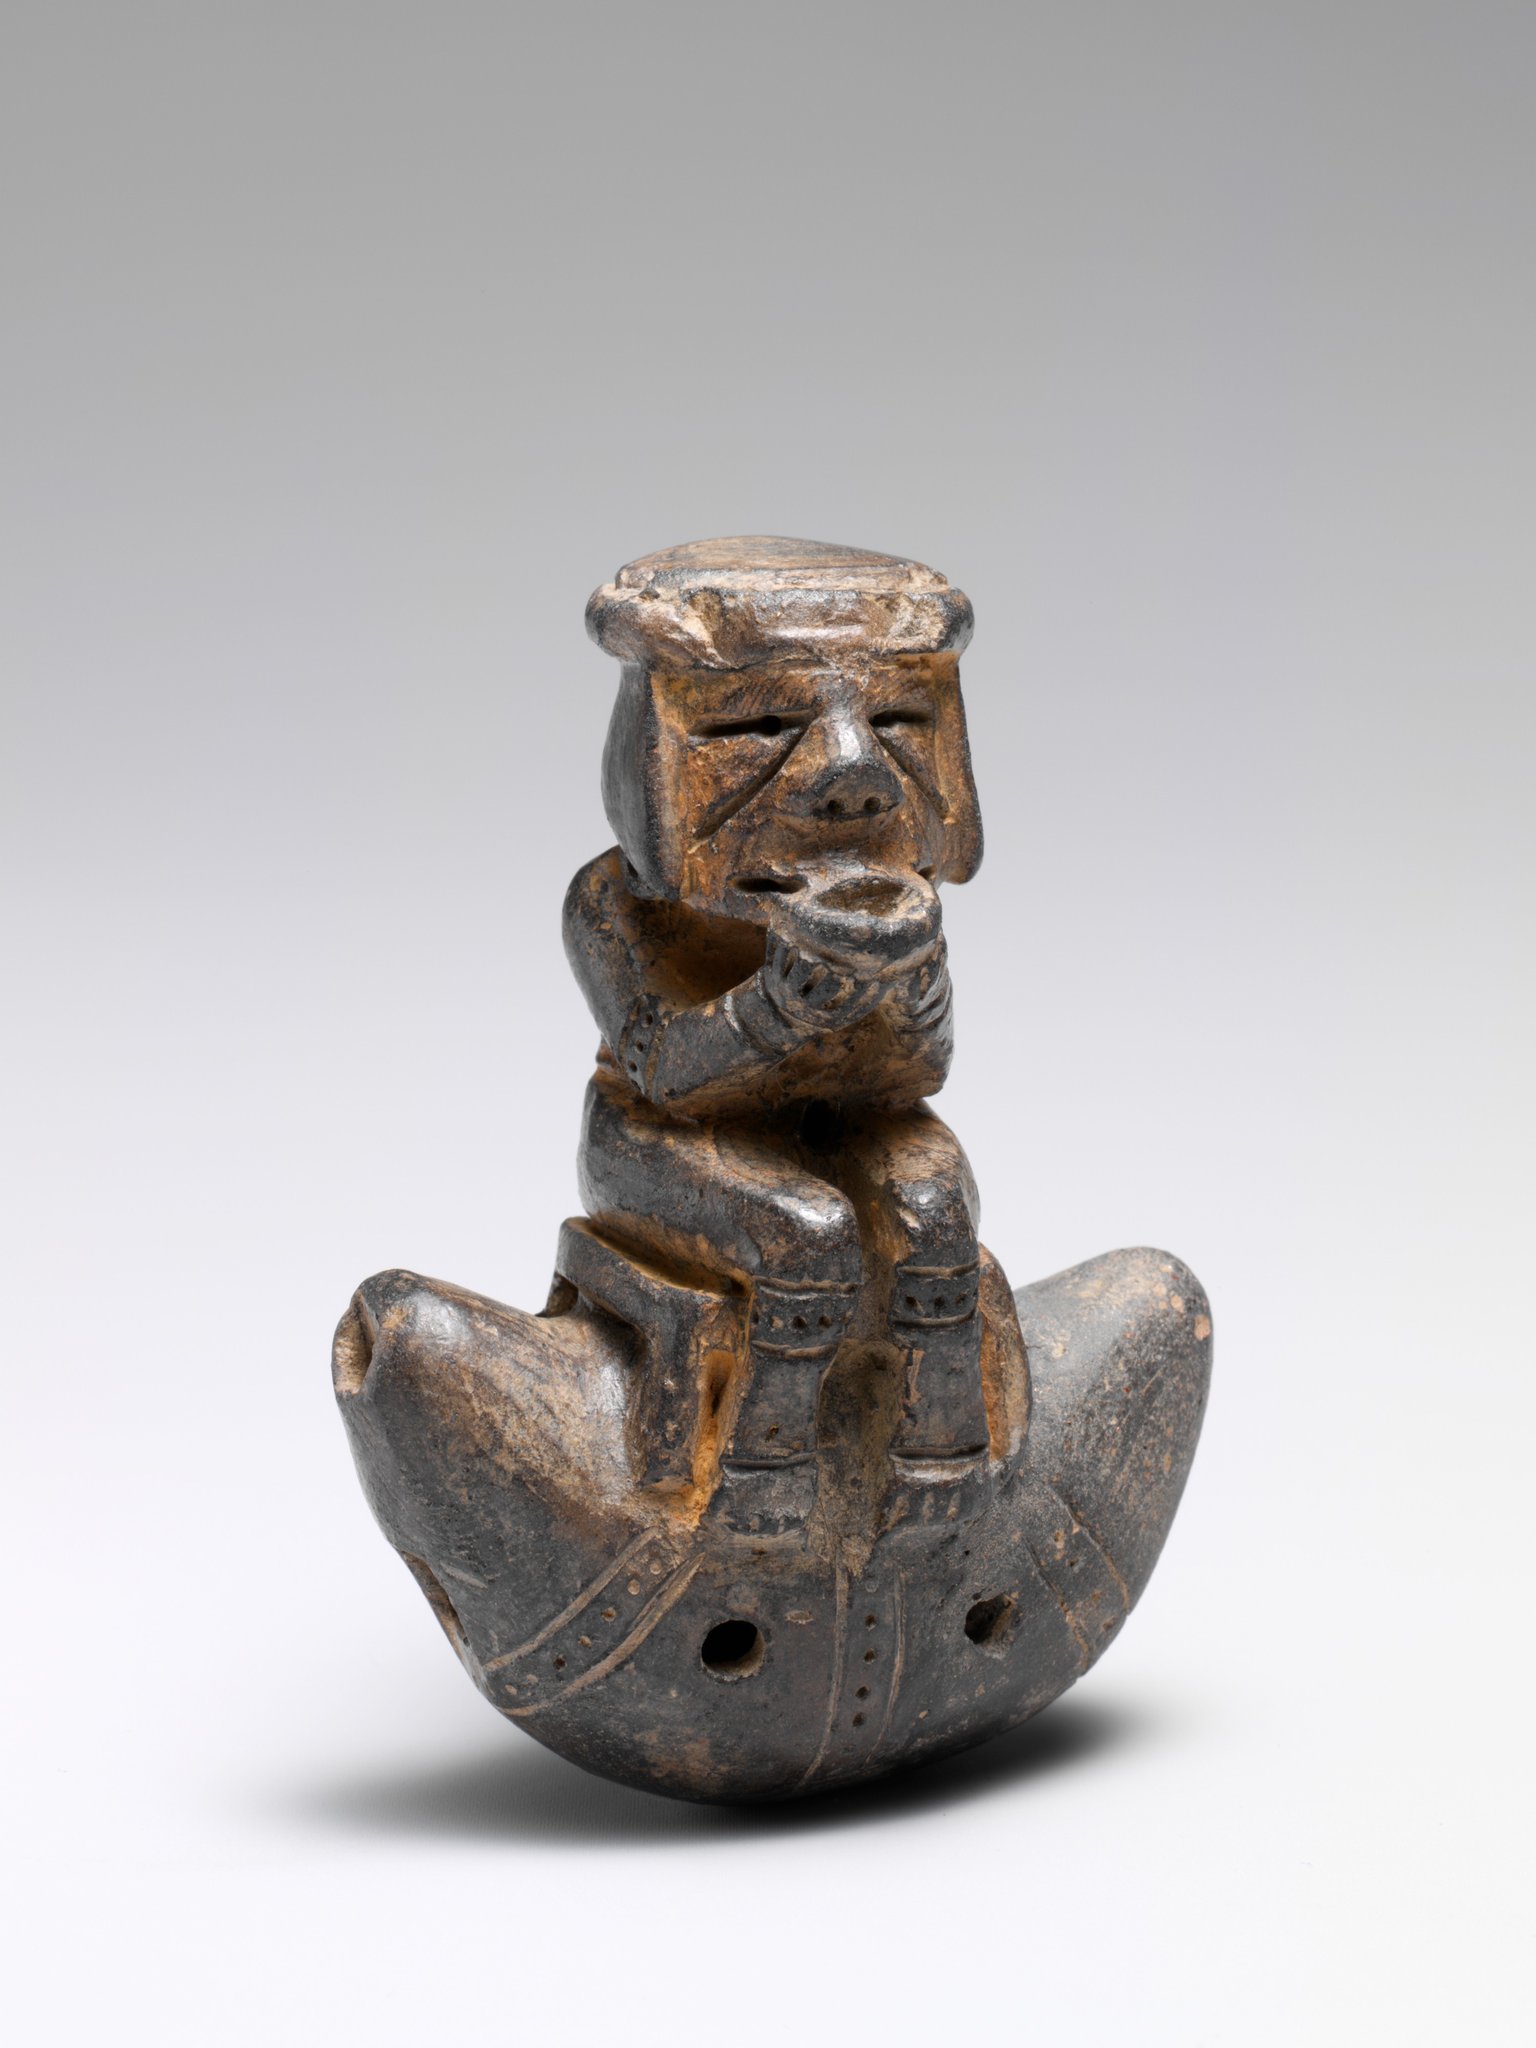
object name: ocarina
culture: tairona, gayraca style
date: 1300-1500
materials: ceramic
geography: colombia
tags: human figures